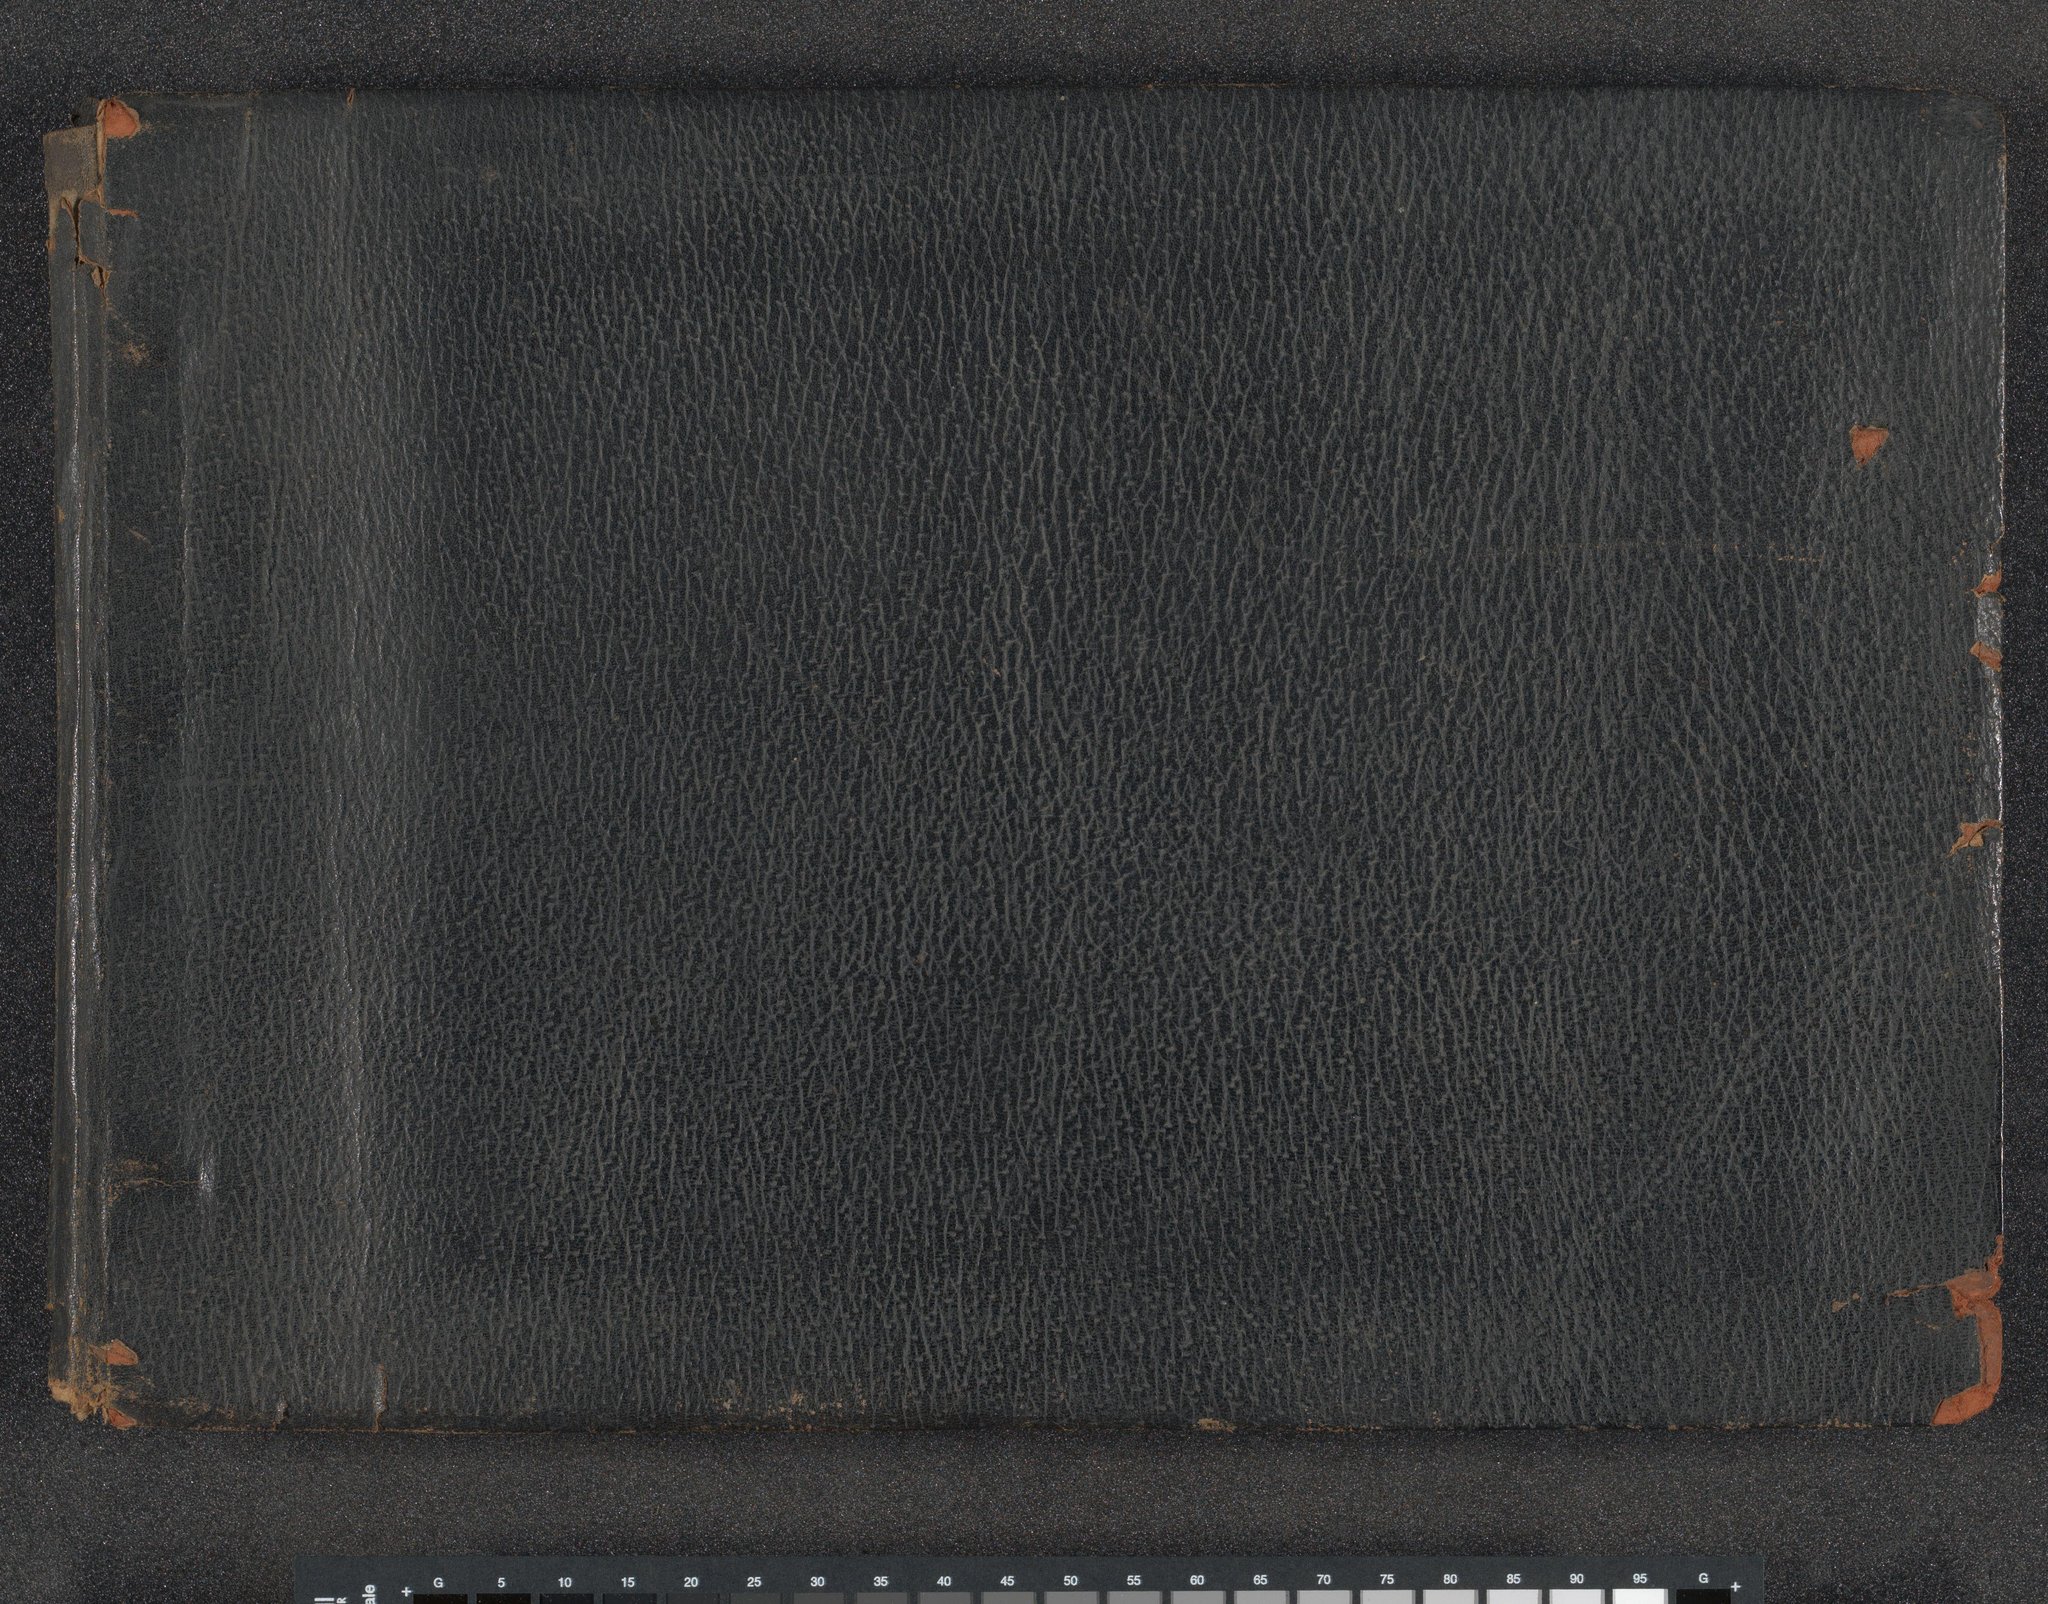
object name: photograph album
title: Reisalbum met veertig foto's van Nederlands-Indië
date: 1900-1930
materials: leather, linen, metal, paper, photographic support, fiber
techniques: gelatin silver print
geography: dutch east indies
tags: travelling; tourism, dutch east indies, the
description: Fotoalbum in zwart omslag van imitatieleer. het boekblok is doorregen met een koord met metalen uiteindes. Het album bevat 40 albumbladen van zwart papier met elk één opgeplakte foto. Het zijn opnames van mensen, landschappen en bezienswaardigheden, gemaakt in Nederlands-Indië.